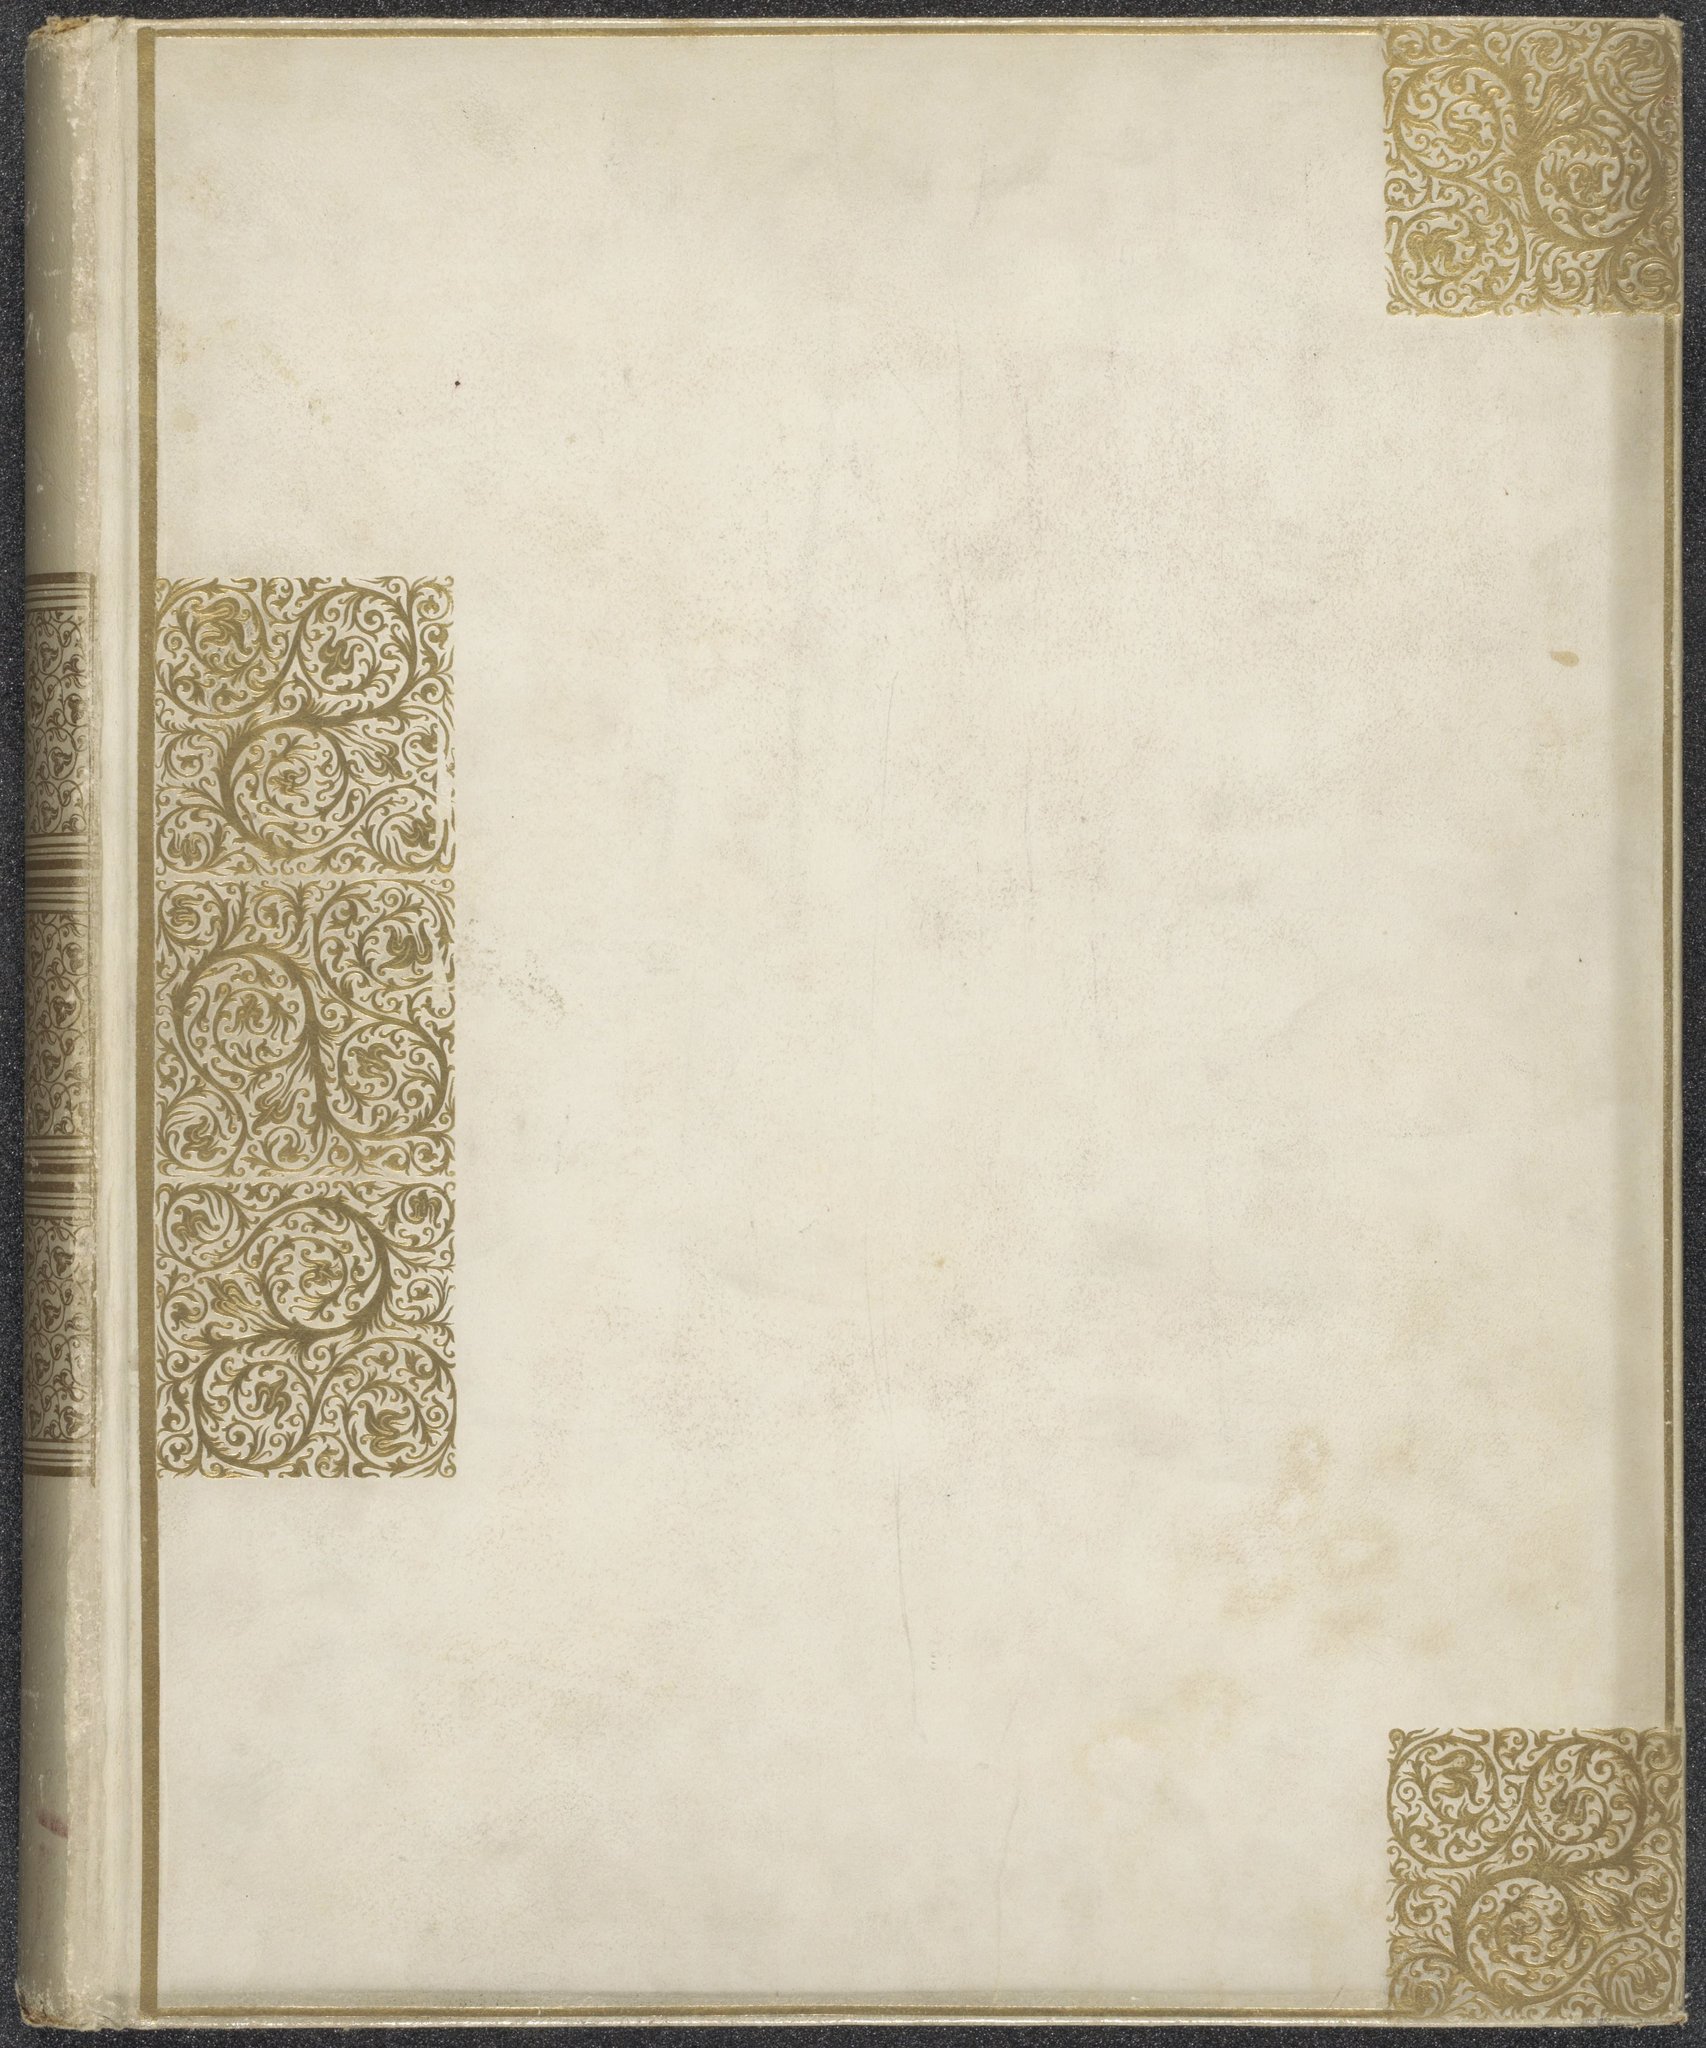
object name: photograph album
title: Reisalbum met foto's van bezienswaardigheden in België en Frankrijk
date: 1860-1900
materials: cardboard, paper, parchment, photographic support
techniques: albumen print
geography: france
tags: travelling; tourism, brussels, france, paris, marseille, belgium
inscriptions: inscription: ‘G. Brogi 1 Via Tornabuoni Firenze’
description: Fotoalbum in band van wit perkament. De rug en het voor- en achterplat zijn versierd met blad- en bloemmotieven in gouddruk. De schutbladen hebben een goud- en groenkleurig fantasiemotief van planten, vazen en beelden en vogels. Het album bevat 39 bladen rood op snee, met 76 foto's van bezienswaardigheden in voornamelijk Brussel, Parijs, Versailles, Marseille en Nice. De samensteller is onbekend. De sticker achterin het album van de in Florence gevestigde fotograaf Giacomo Brogi, doet vermoeden dat de samensteller uit Italië kwam.